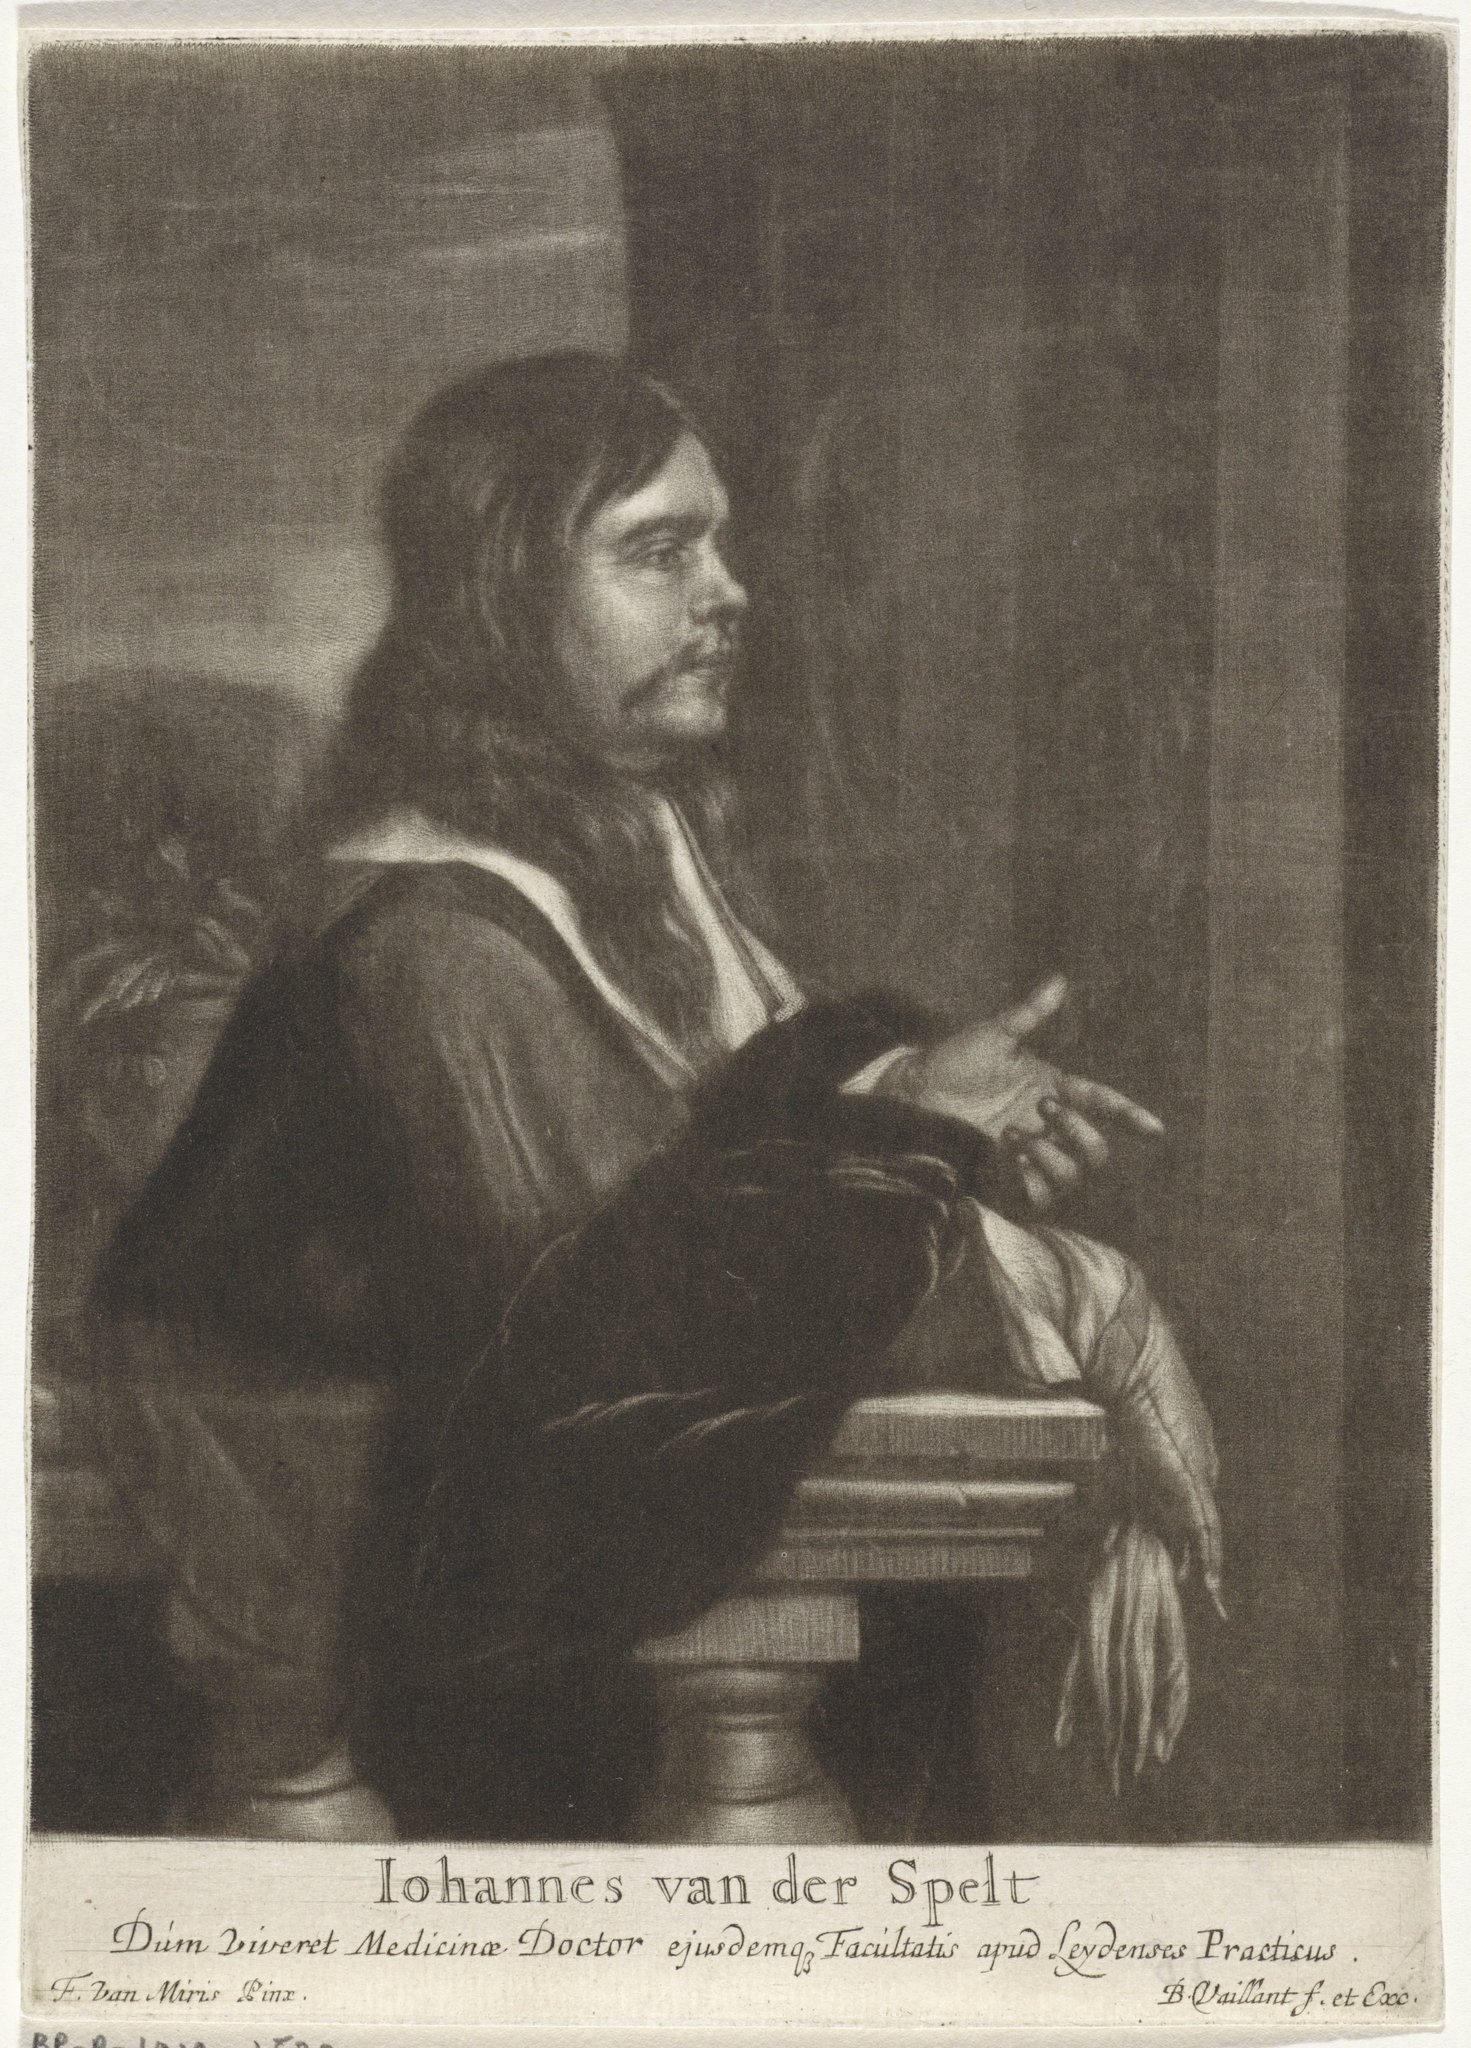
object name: print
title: Portret van Johannes van der Spelt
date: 1663-1698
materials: paper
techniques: mezzotint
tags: gloves, mittens, etc.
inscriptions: collector's mark: Lugt 2228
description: Johannes van der Spelt, professor medicijnen te Leiden, in profiel. Hij staat op een terras en heeft een van zijn handschoenen uitgetrokken.